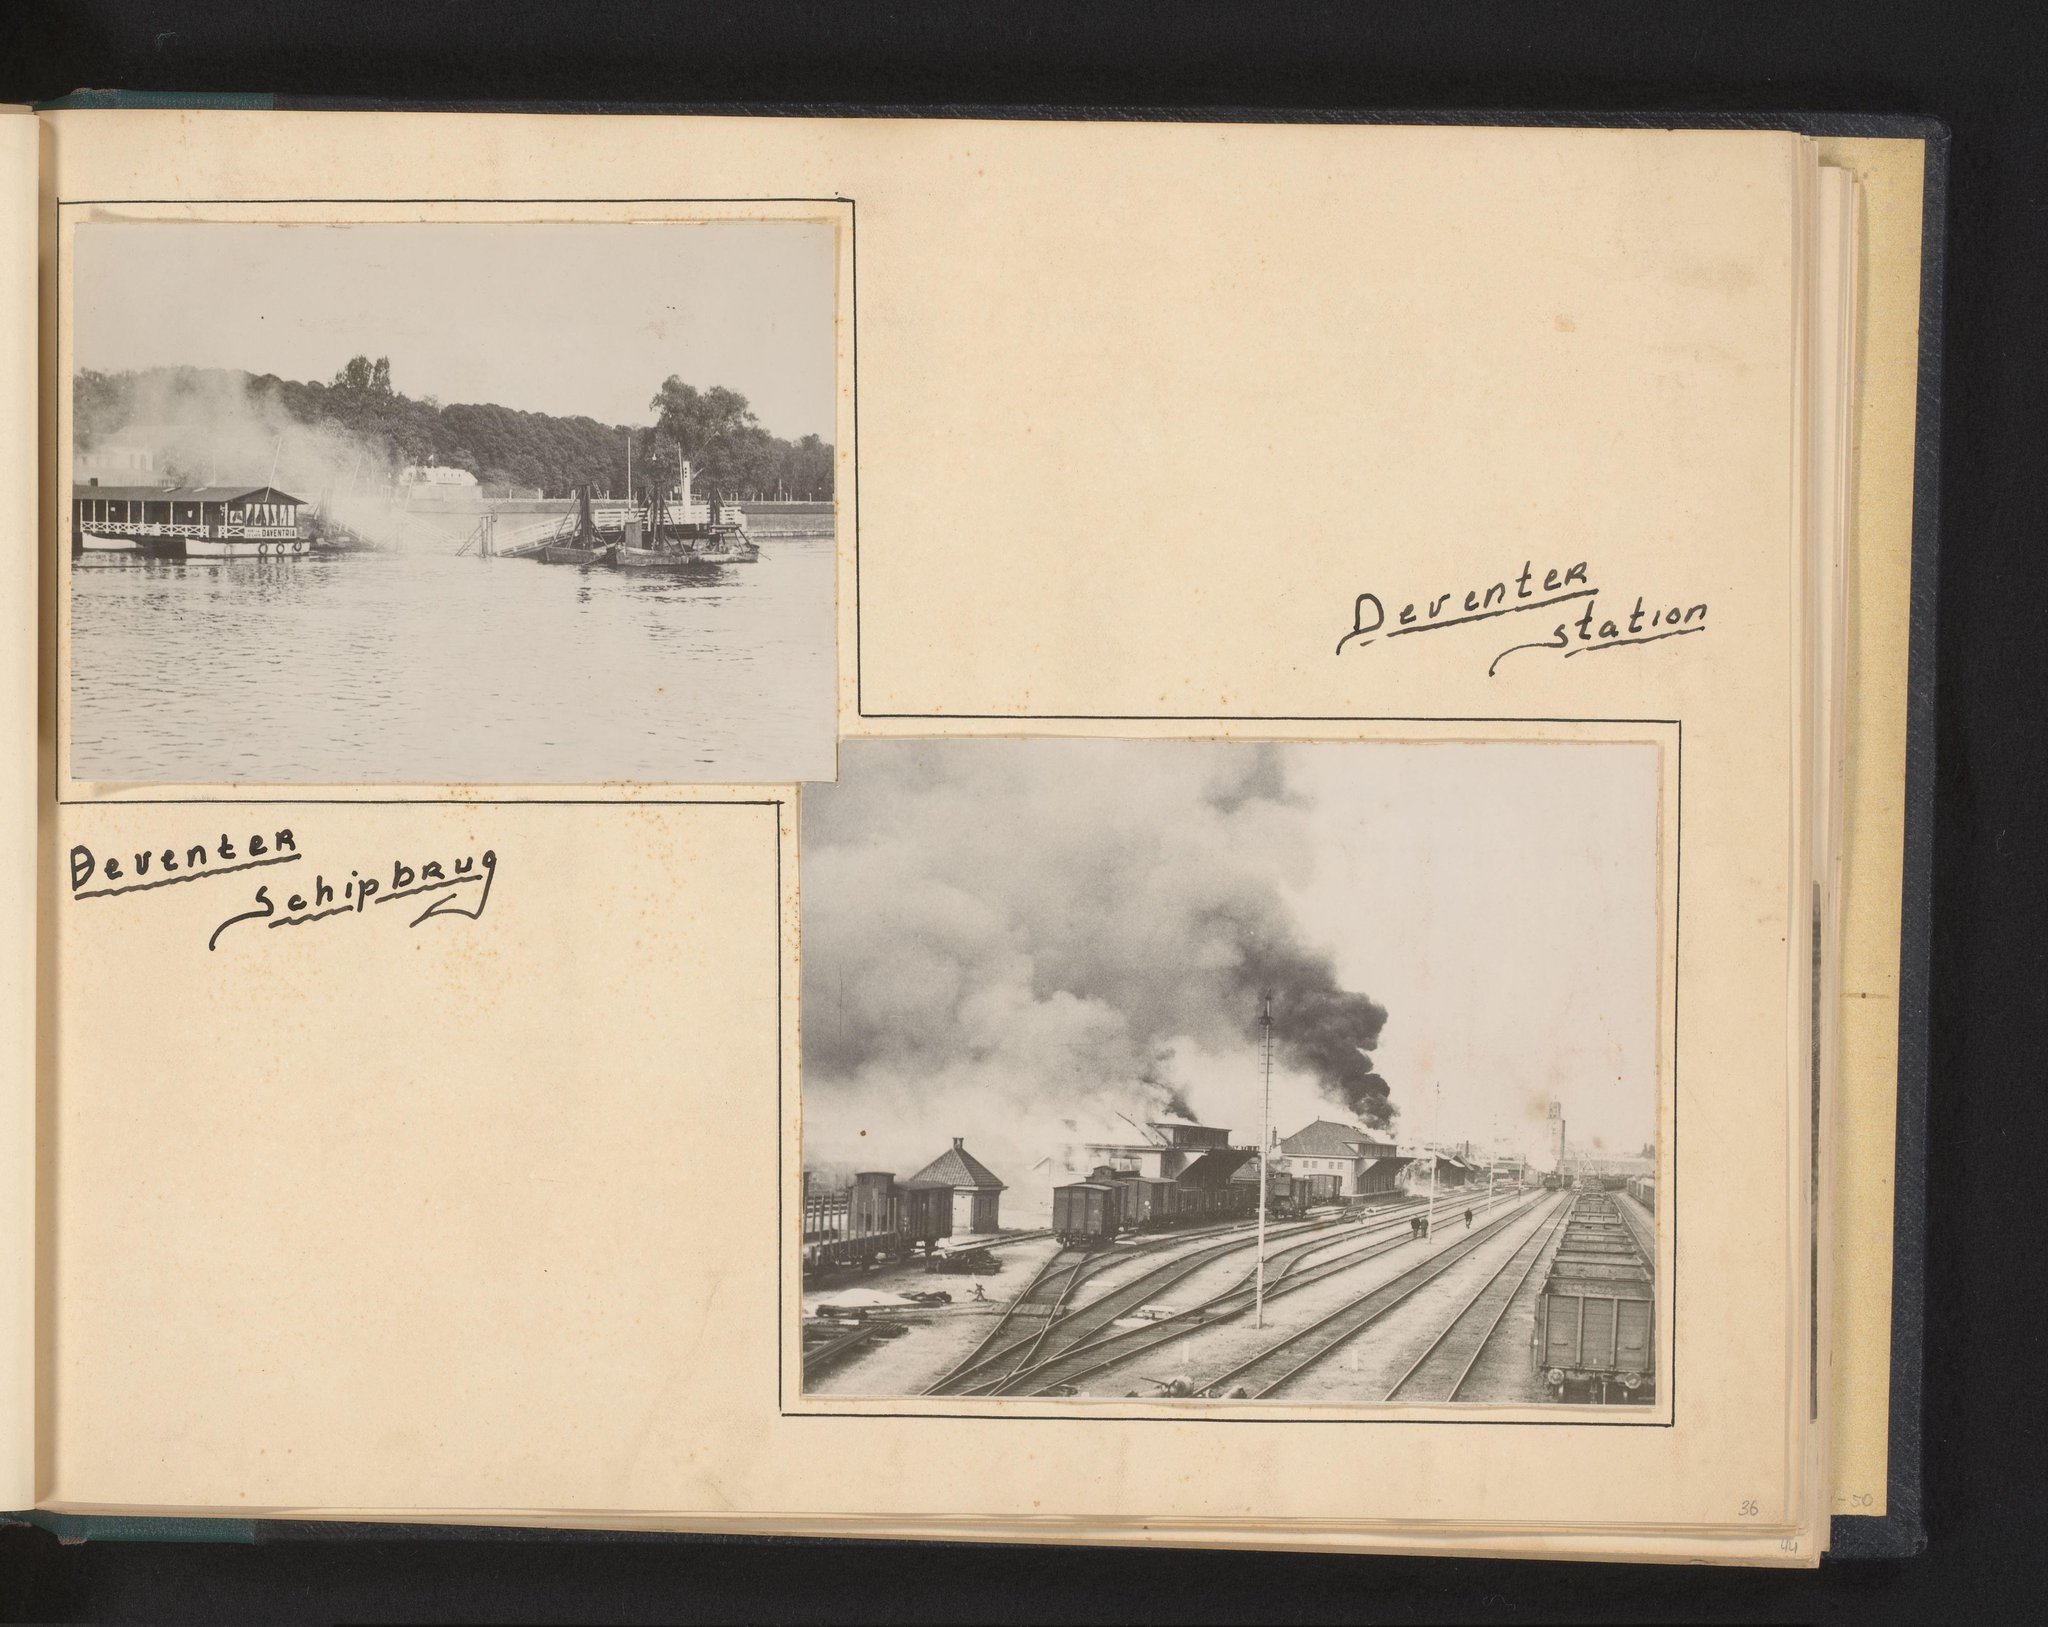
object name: photograph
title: Verwoestingen te Deventer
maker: arnoldus vrauwdêunt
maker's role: graficus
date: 1940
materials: cardboard, photographic support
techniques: gelatin silver print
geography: deventer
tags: obstructions, barricades (defensive measures), station; shelter (railway, tramway), railway, tramway; rack railway, bridge, netherlands, deventer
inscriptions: inscription: ‘Deventer Schipbrug / Deventer station’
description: Albumblad met twee foto's van verwoestingen in Deventer. De oude Deventer Schipbrug werd opgeblazen in een poging de opmars van het Duitse leger te bemoeilijken, 10 mei 1940. Ook het station in Deventer staat in brand. Onderdeel van het fotoalbum over de verwoestingen van Nederlandse steden en infrastructuur in het begin van de Tweede Wereldoorlog.